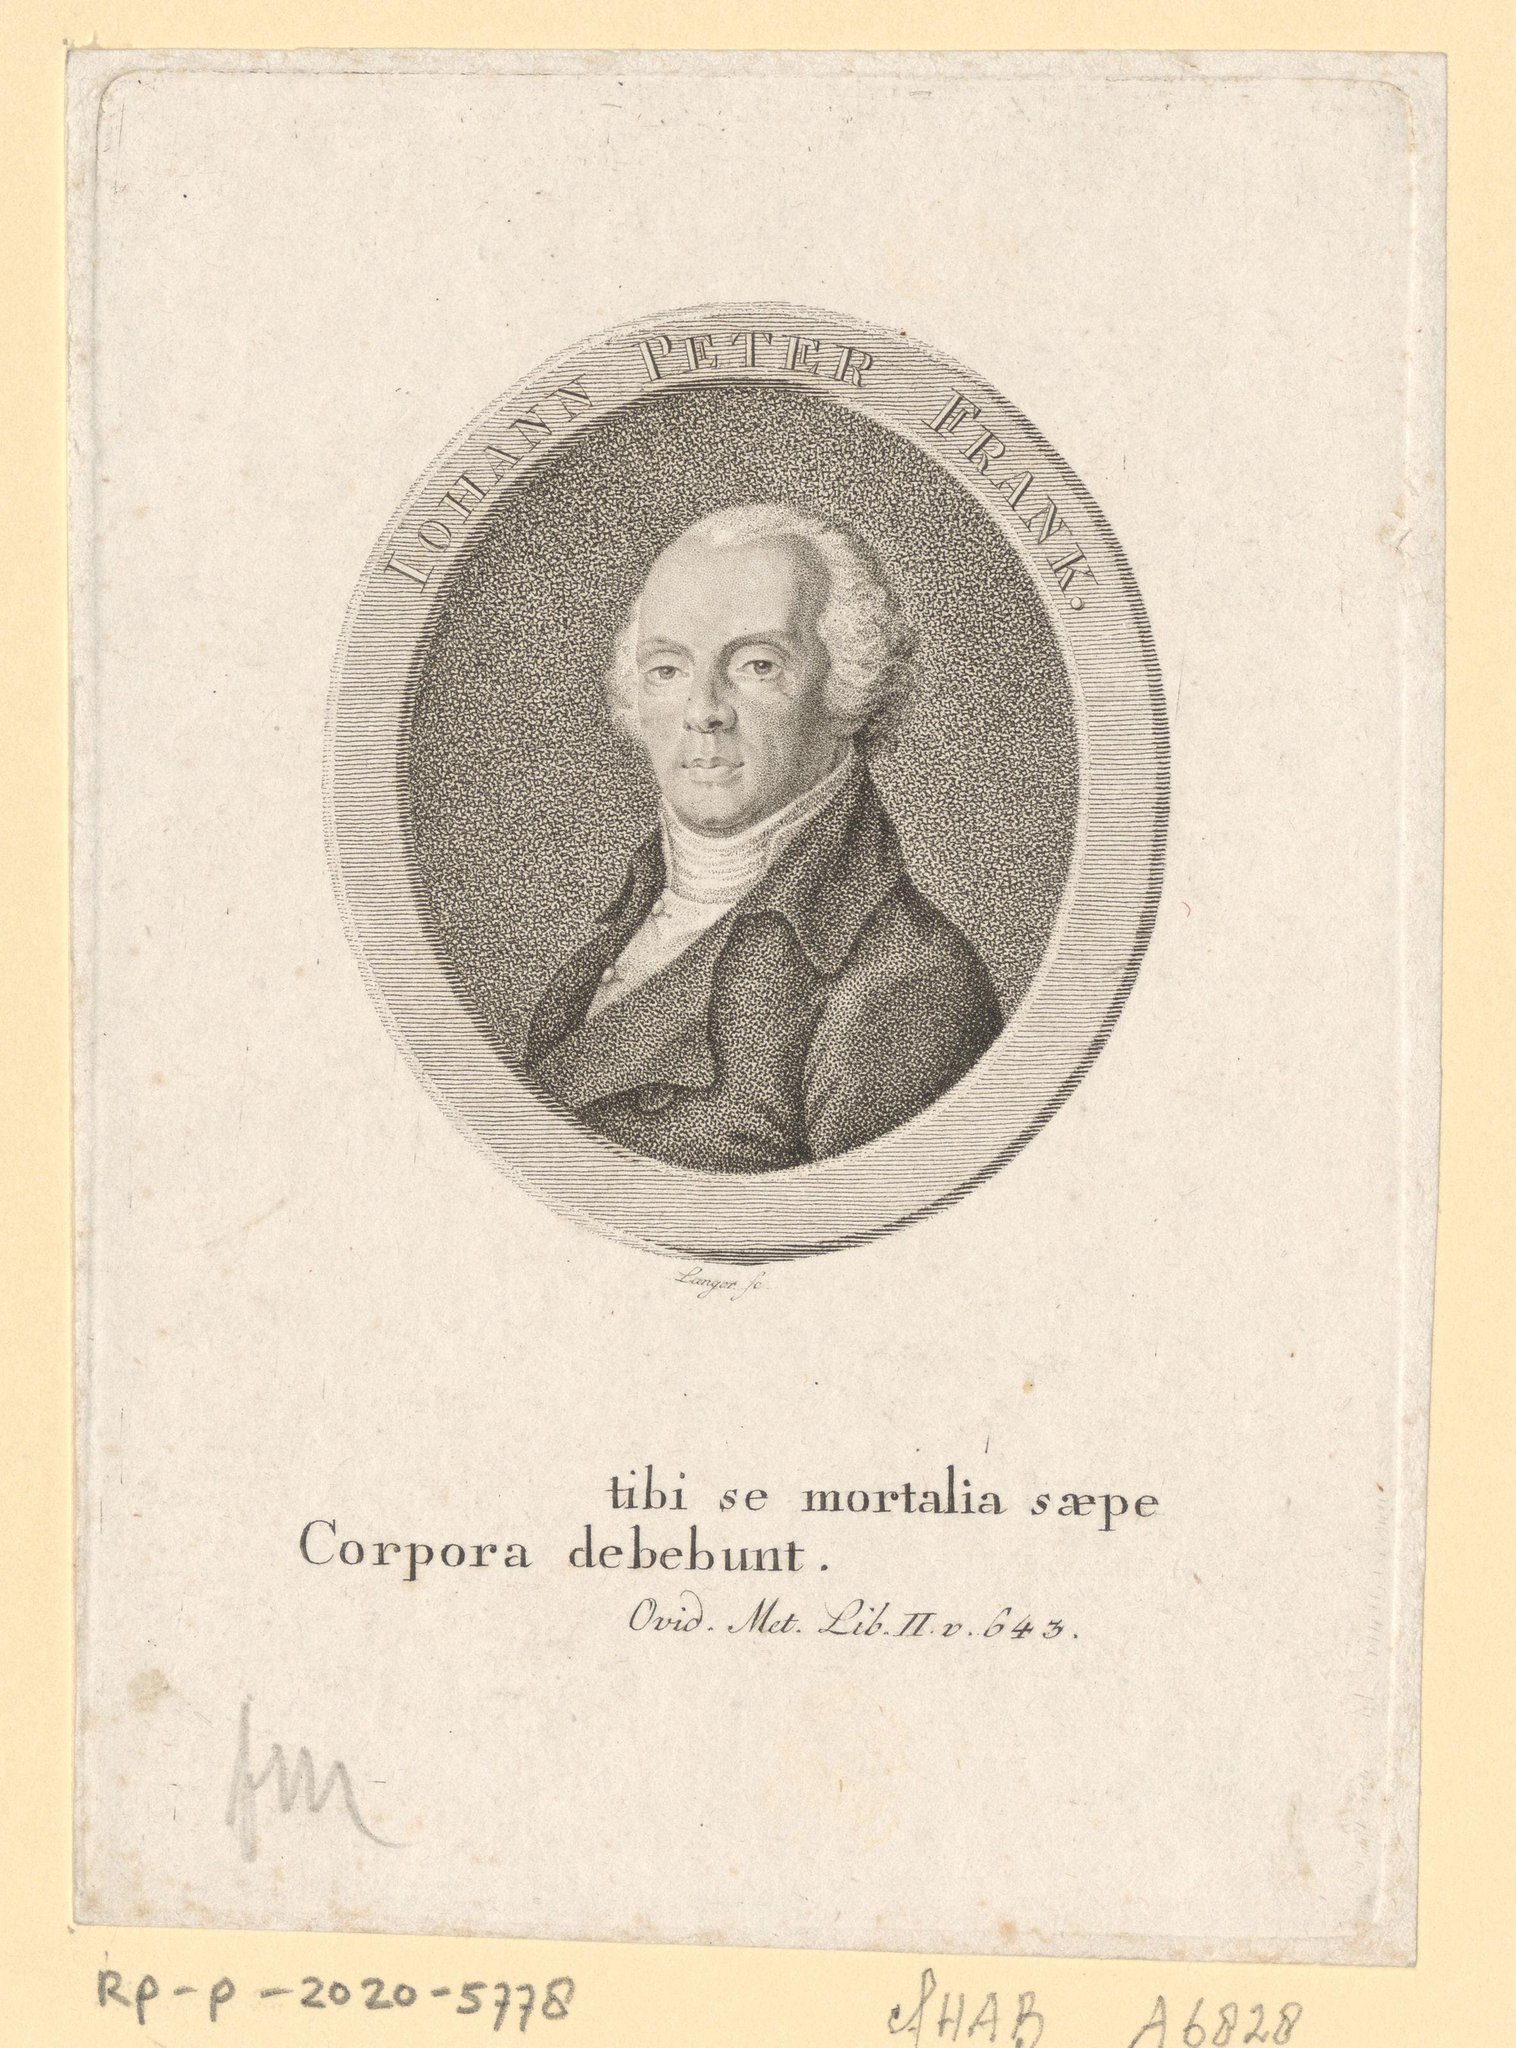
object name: print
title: Portret van Johann Peter Frank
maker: sebastian langer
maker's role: print maker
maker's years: 1772-1841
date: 1790-1841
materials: paper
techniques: etching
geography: germany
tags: vienna, historical persons, physician, doctor (+ portrait of scholar, scientist)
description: Met twee regels in het Latijn uit Ovidius' Metamorfosen onder het portret.